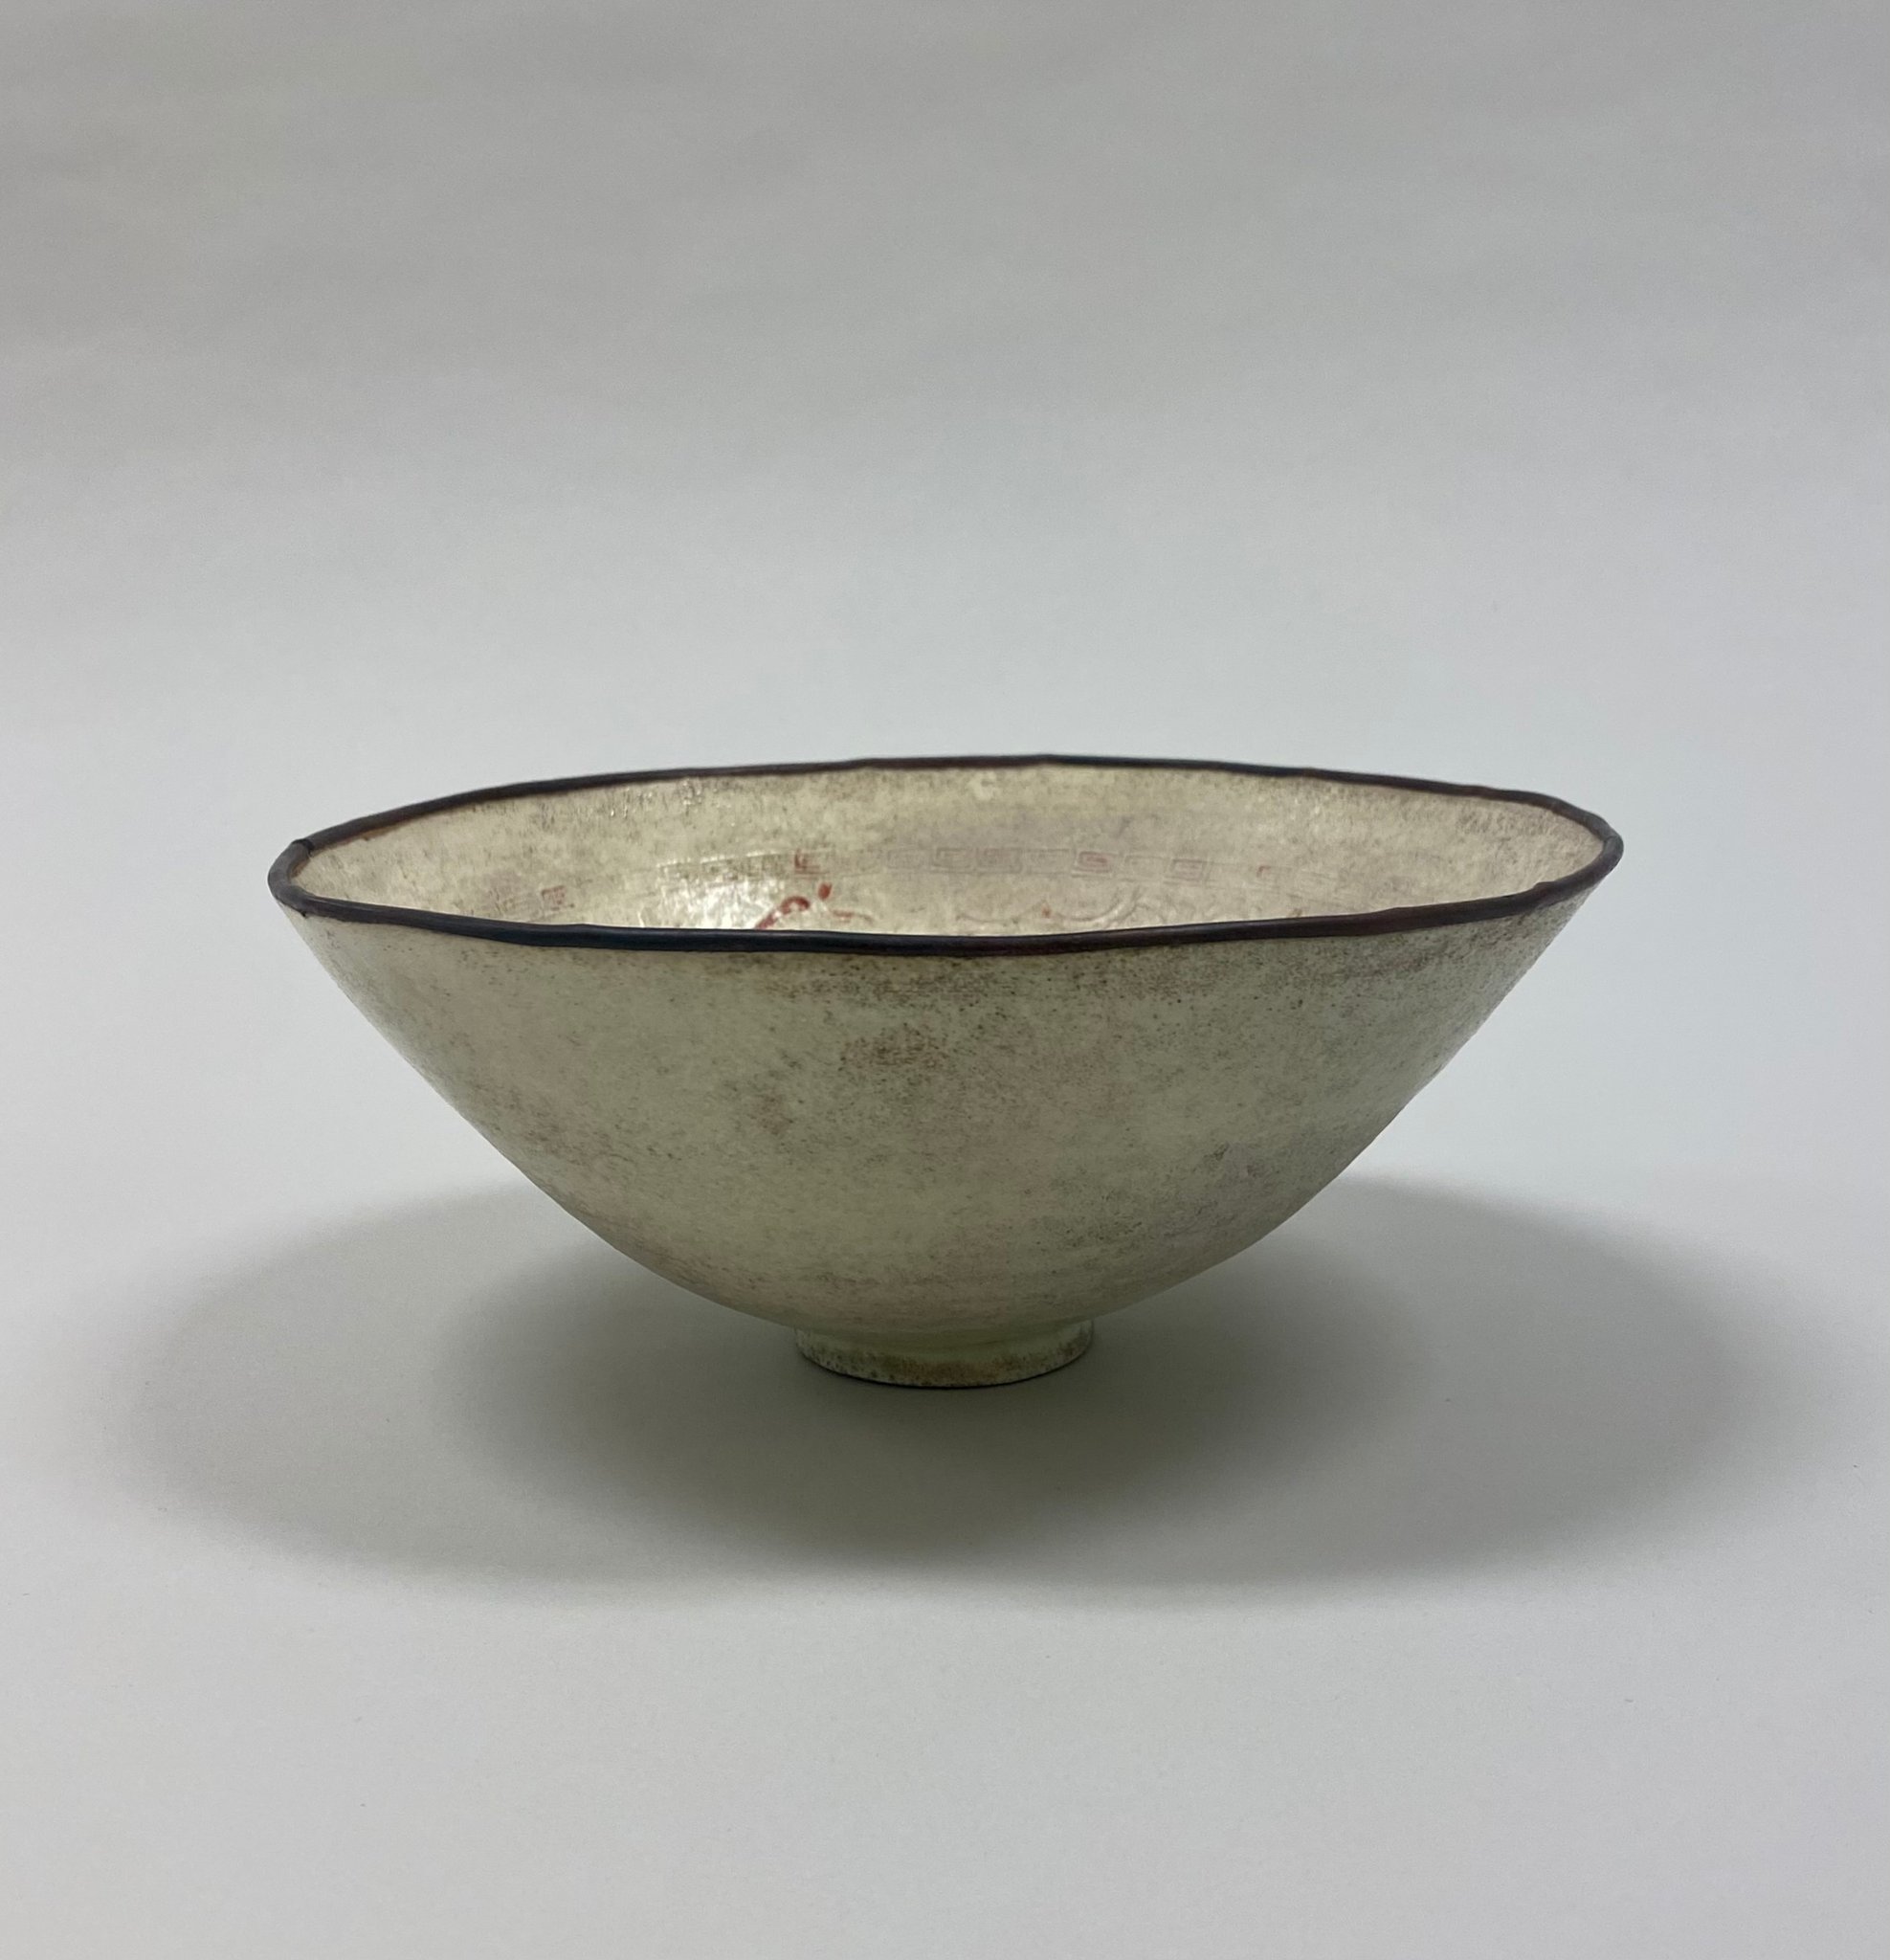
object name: bowl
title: Bowl with birds and flowers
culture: chinese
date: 1567-1633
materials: porcelain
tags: birds